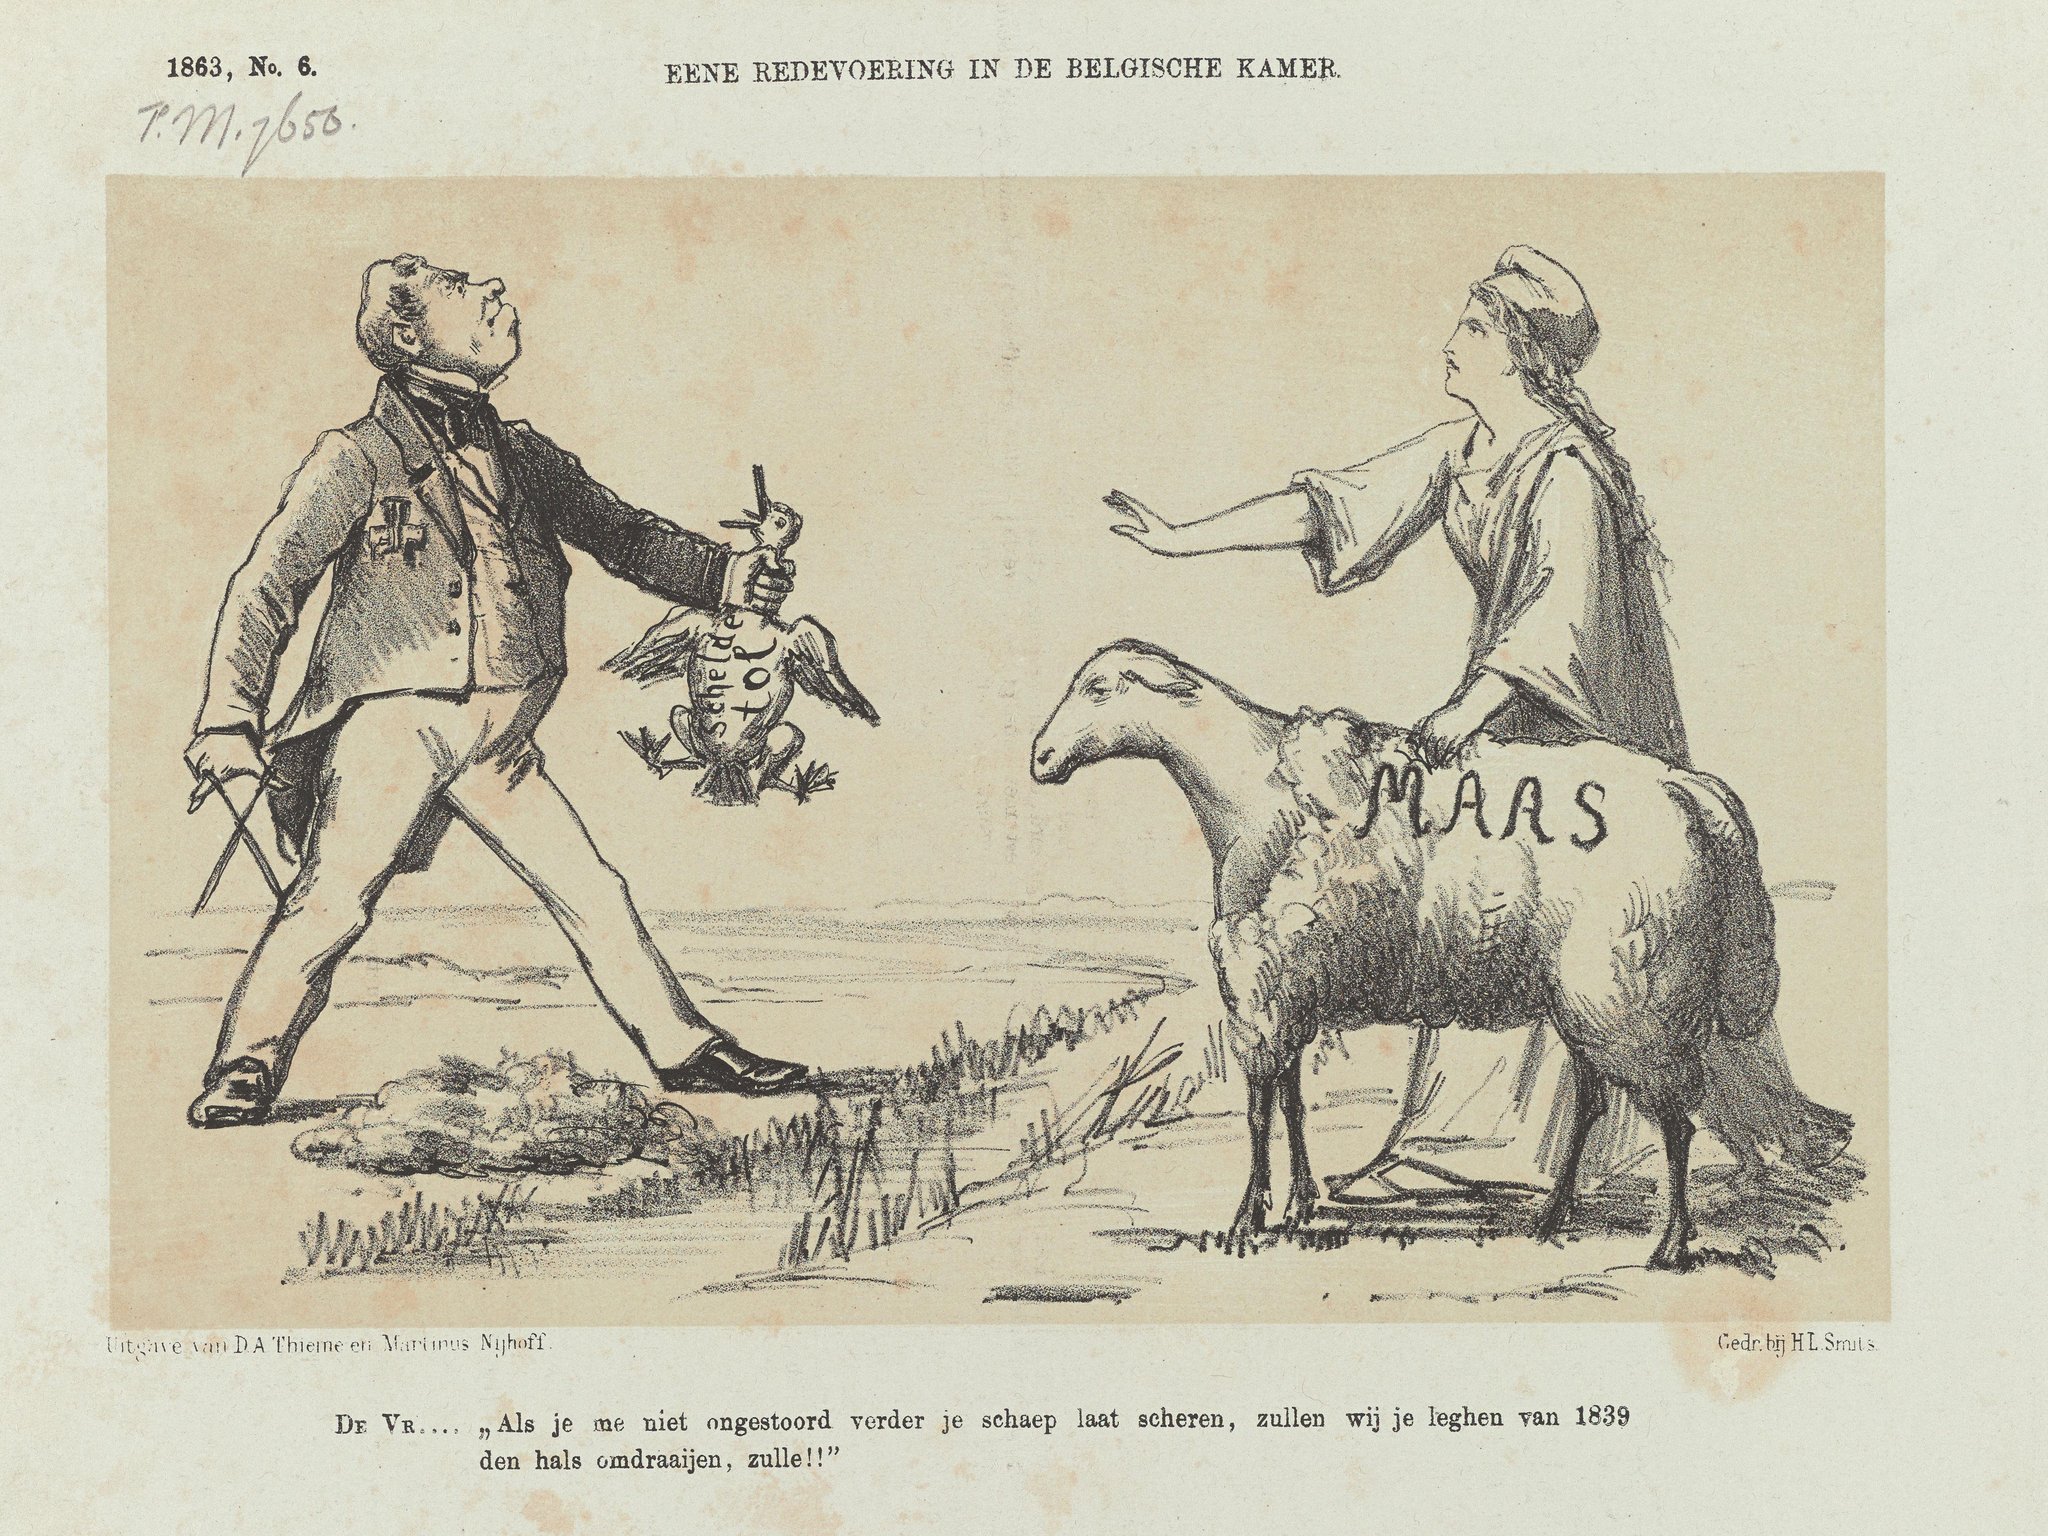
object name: cartoon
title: Spotprent op de Belgische politiek over de Schelde en de Maas, 1863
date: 1863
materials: paper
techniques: tone lithography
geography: netherlands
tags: toll gate, shearing (sheep), belgium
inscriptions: collector's mark: Lugt 2228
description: Spotprent op de Belgische politiek ten aanzien van de Schelde en de Maas. Een Belgische politicus dreigt een de eend 'Scheldetol' de nek om te draaien als hij het Nederlandse schaap 'Maas' niet verder mag scheren. Plaat verschenen bij het weekblad De Nederlandsche Spectator, nr. 6, 7 februari 1863.